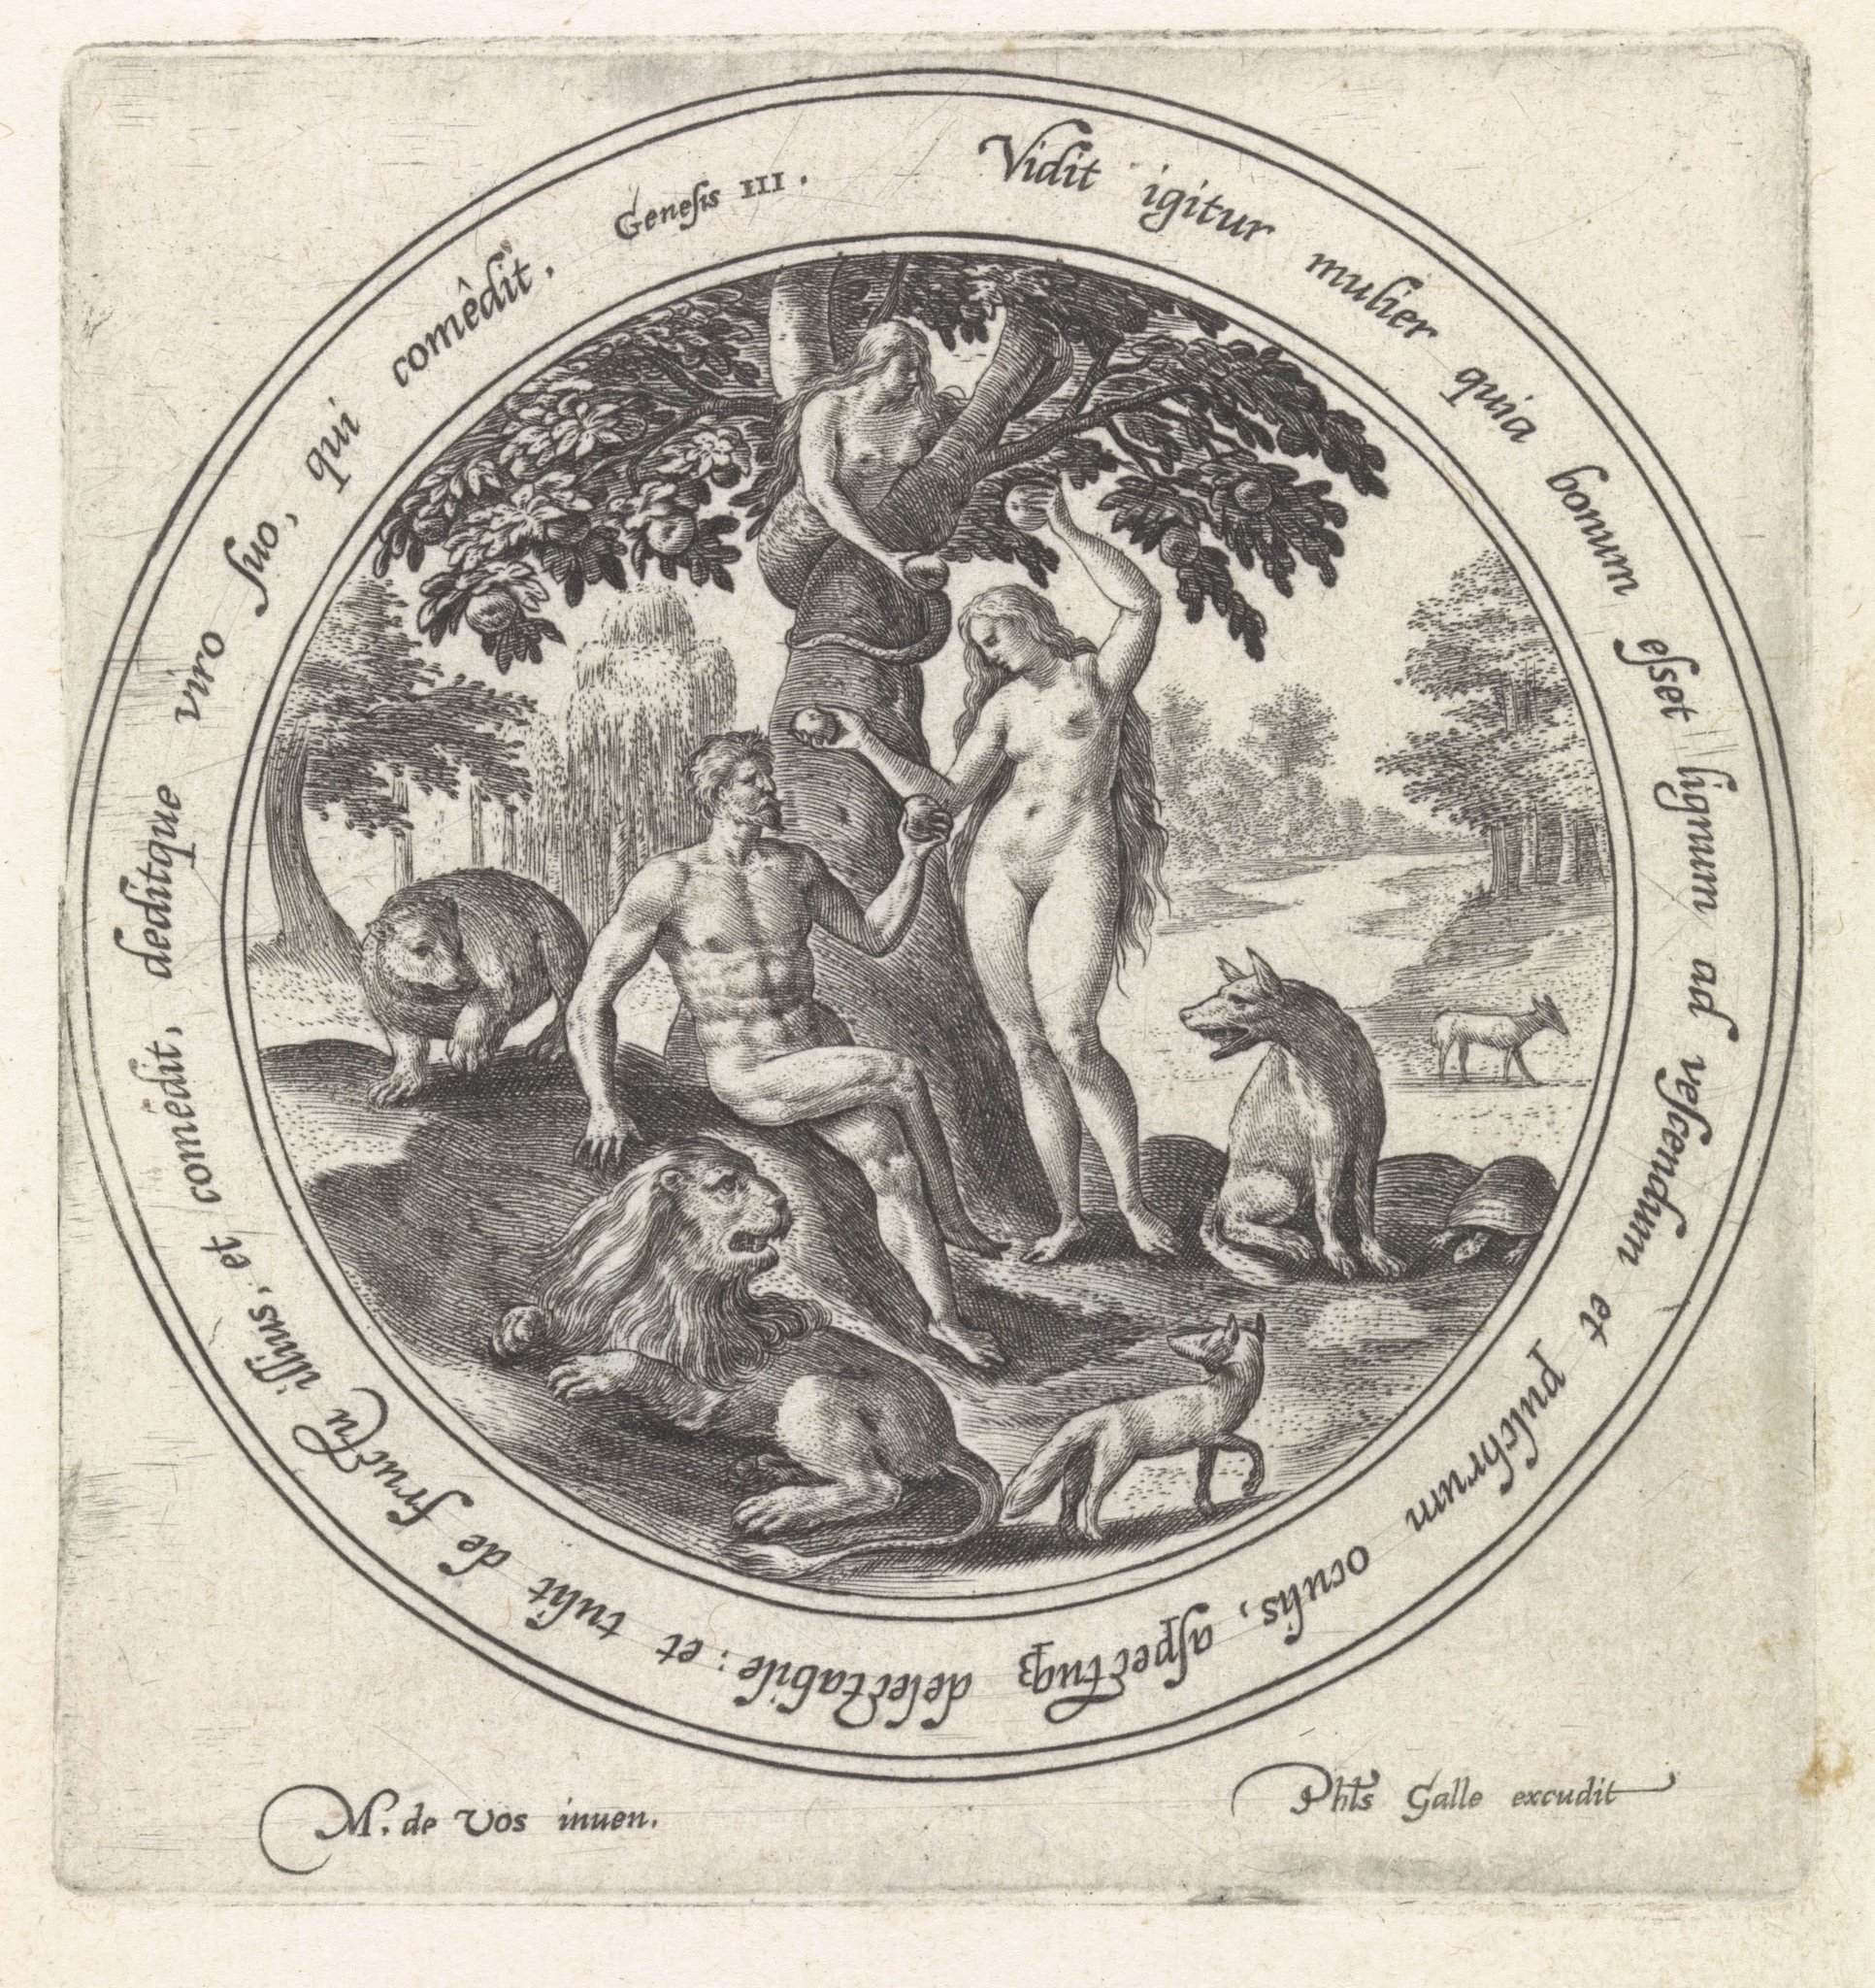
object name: print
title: Eva biedt Adam de verboden vrucht aan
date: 1580-1588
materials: paper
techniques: engraving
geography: antwerp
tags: eve simultaneously offers some of the fruit to adam and takes some more from the serpent (or the tree)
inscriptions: collector's mark: Lugt 2760, collector's mark: Lugt 2228, number: ‘4’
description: Adam en Eva tussen de dieren in het paradijs. Eva krijgt een vrucht van de boom van kennis van goed en kwaad aangereikt door de slang en biedt tegelijkertijd Adam een vrucht aan. In het randschrift van de omlijsting een Bijbelcitaat uit Gen. in het Latijn.